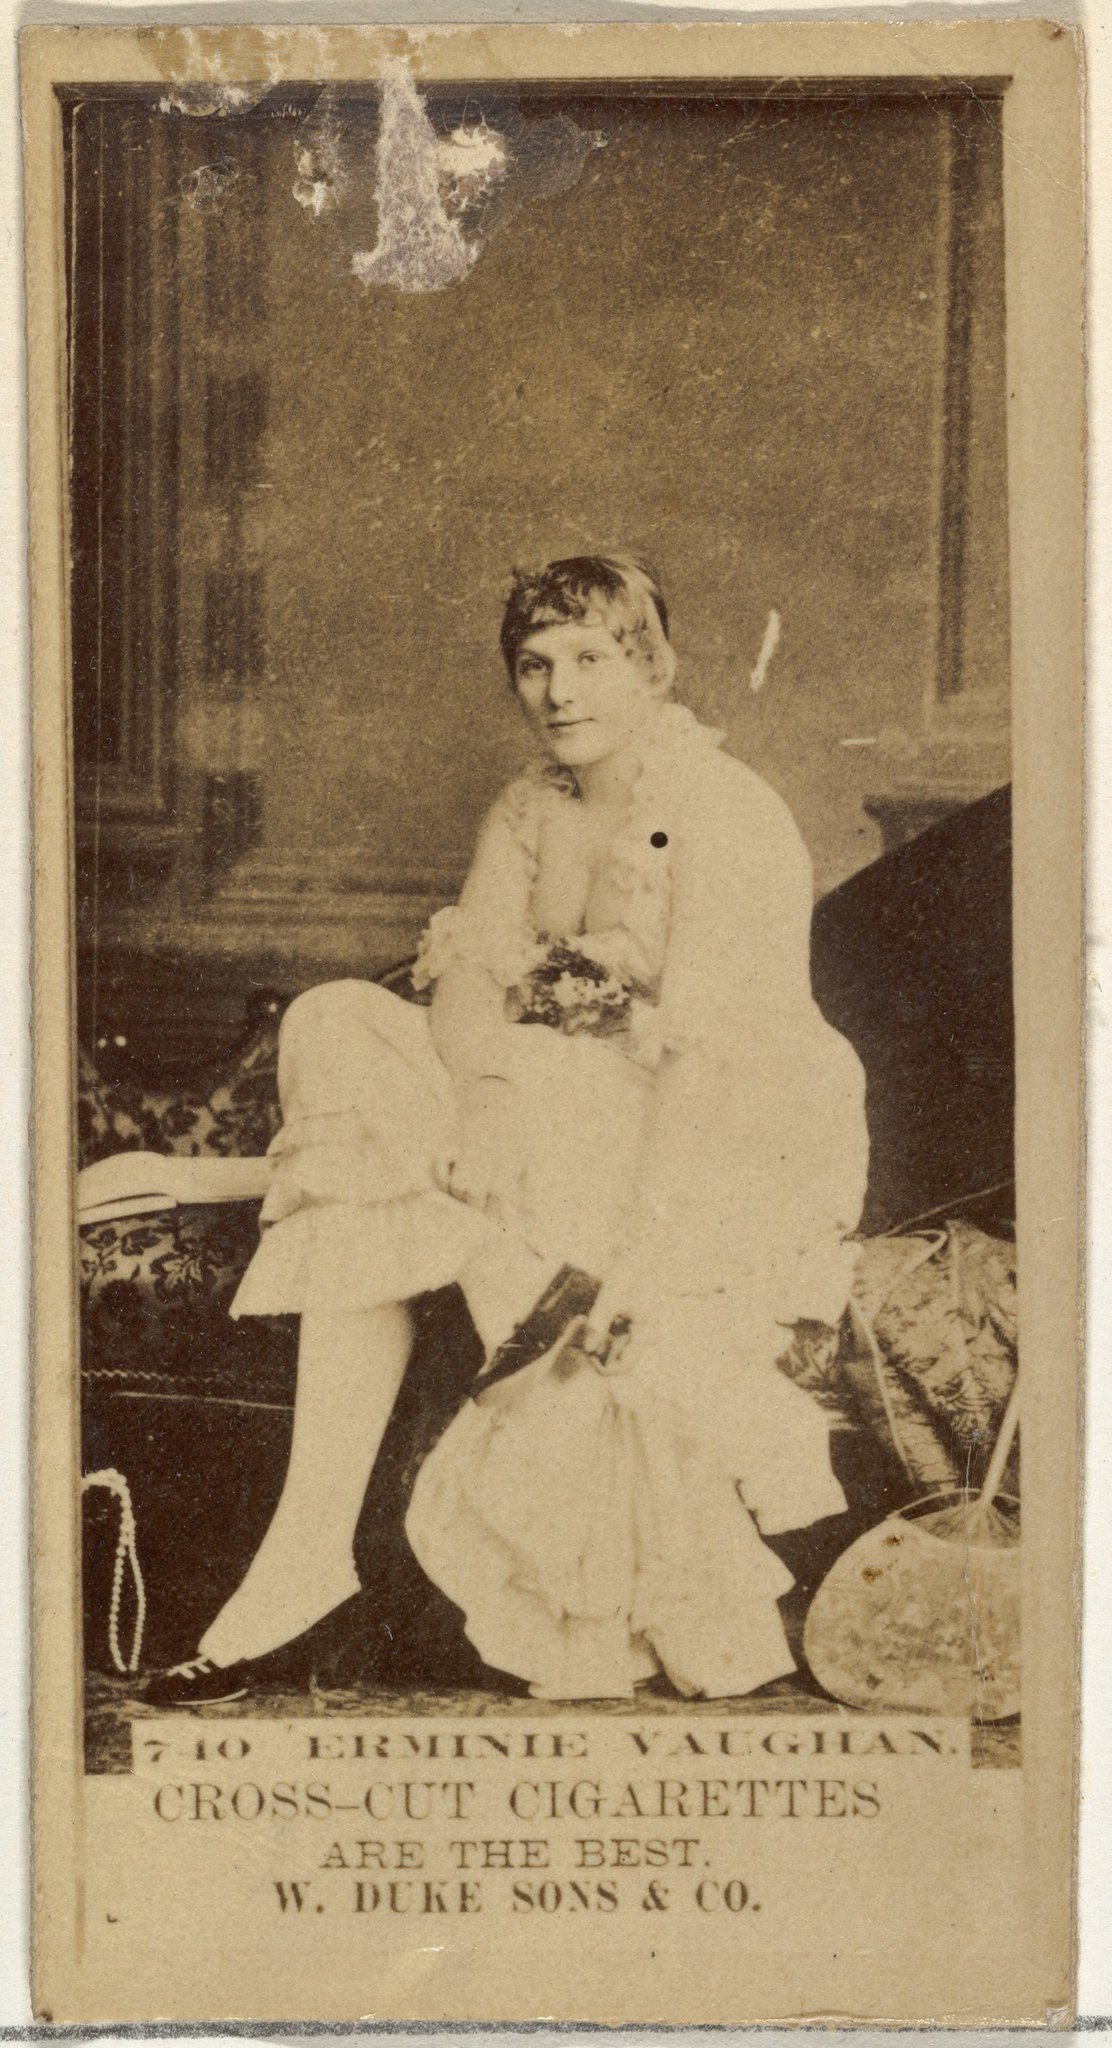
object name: photograph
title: Card Number 740, Erminie Vaughan, from the Actors and Actresses series (N145-3) issued by Duke Sons & Co. to promote Cross Cut Cigarettes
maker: w. duke, sons & co.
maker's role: publisher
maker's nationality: american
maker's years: 1870-1920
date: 1880-1889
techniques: albumen silver print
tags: portraits,women,actresses